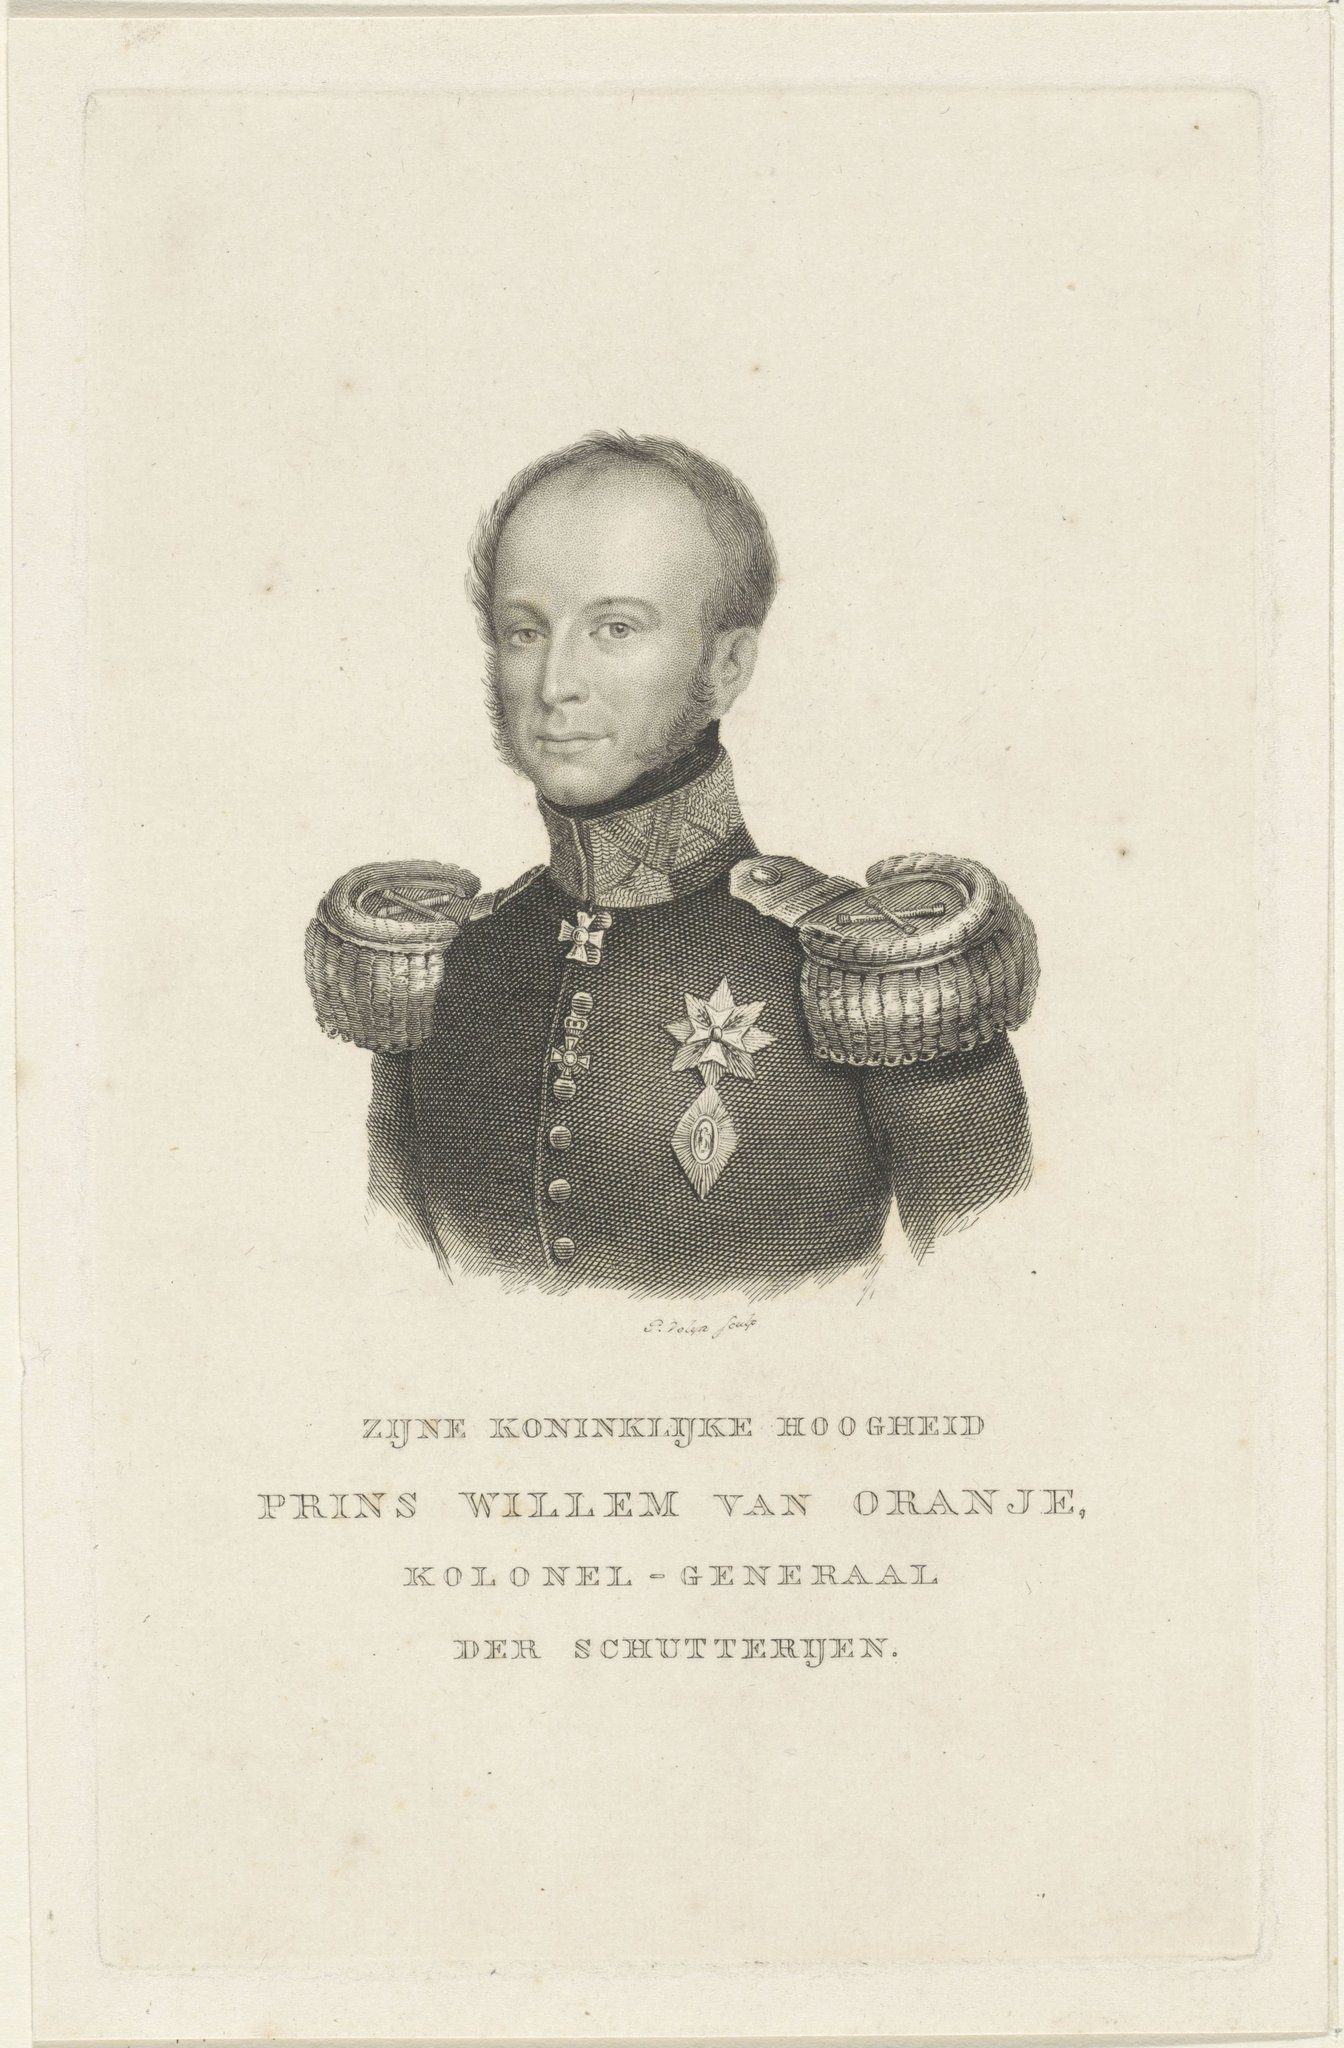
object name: print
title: Portret van Willem II, koning der Nederlanden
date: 1810-1836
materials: paper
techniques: engraving, etching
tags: william ii of the netherlands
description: De hier vermelde titel verwijst naar de hoogst verkregen titel van de geportretteerde, niet per se naar de titel die de geportretteerde op deze voorstelling draagt.